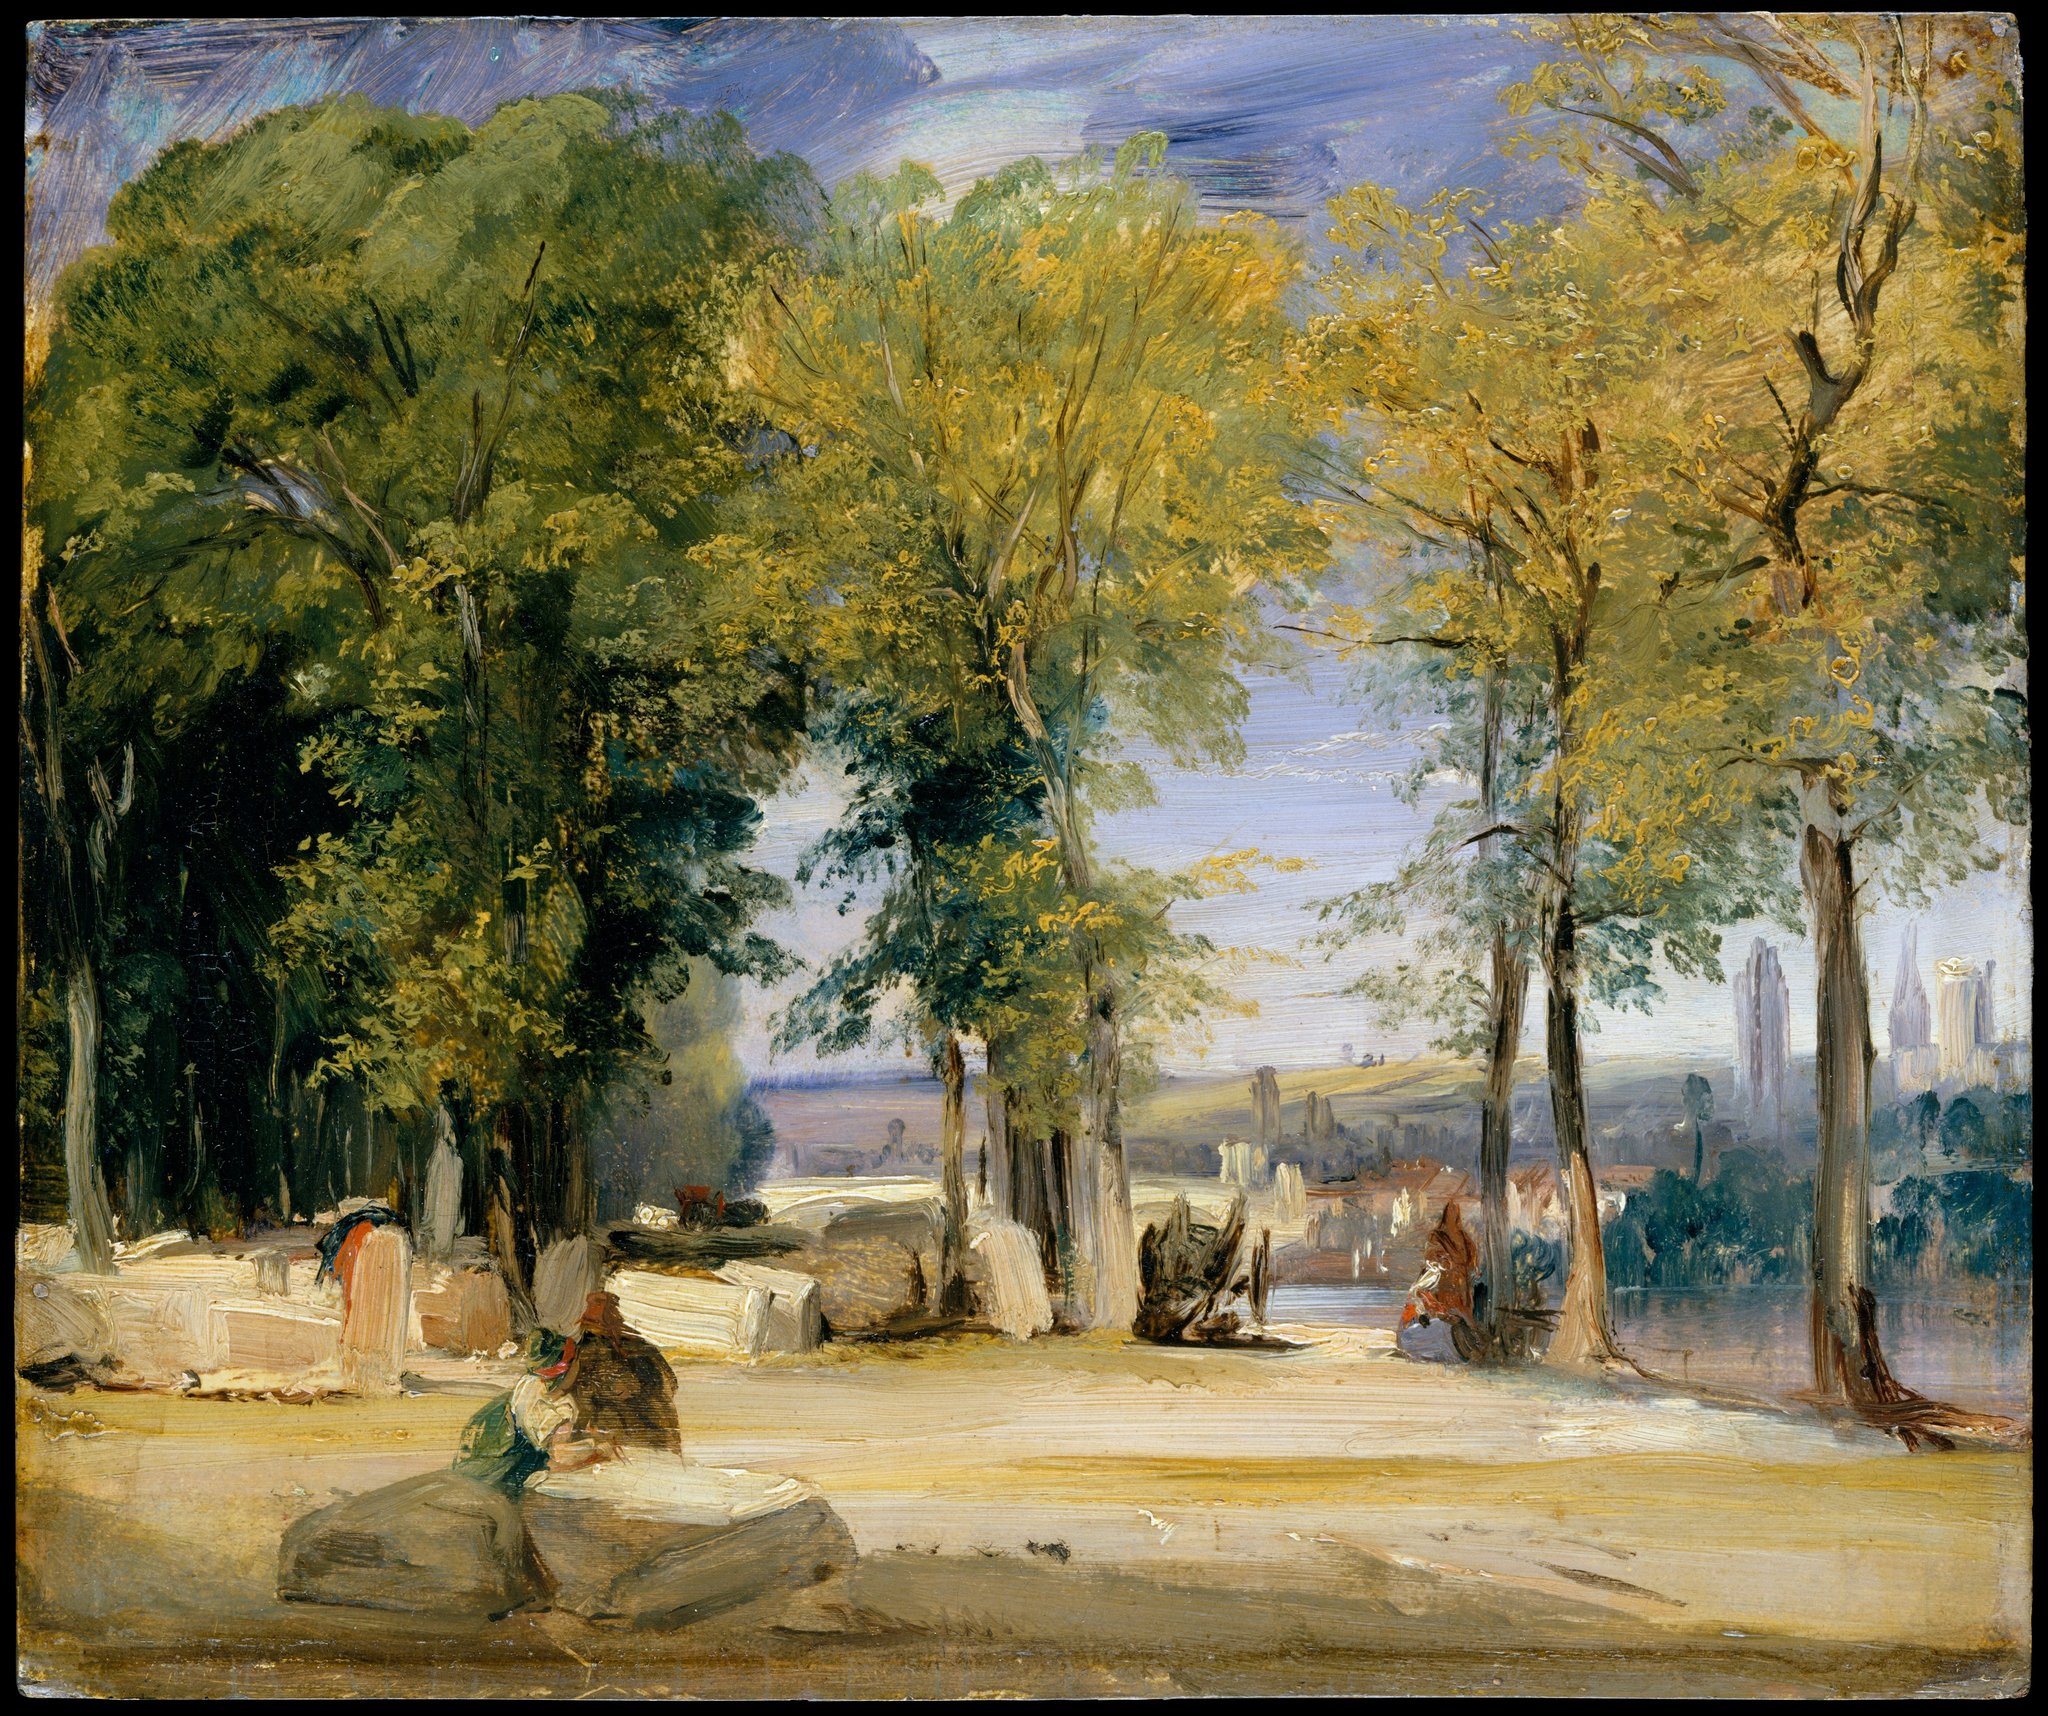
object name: painting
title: View near Rouen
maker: richard parkes bonington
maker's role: artist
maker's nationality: british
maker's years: 1802-1828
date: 1825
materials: oil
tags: landscapes